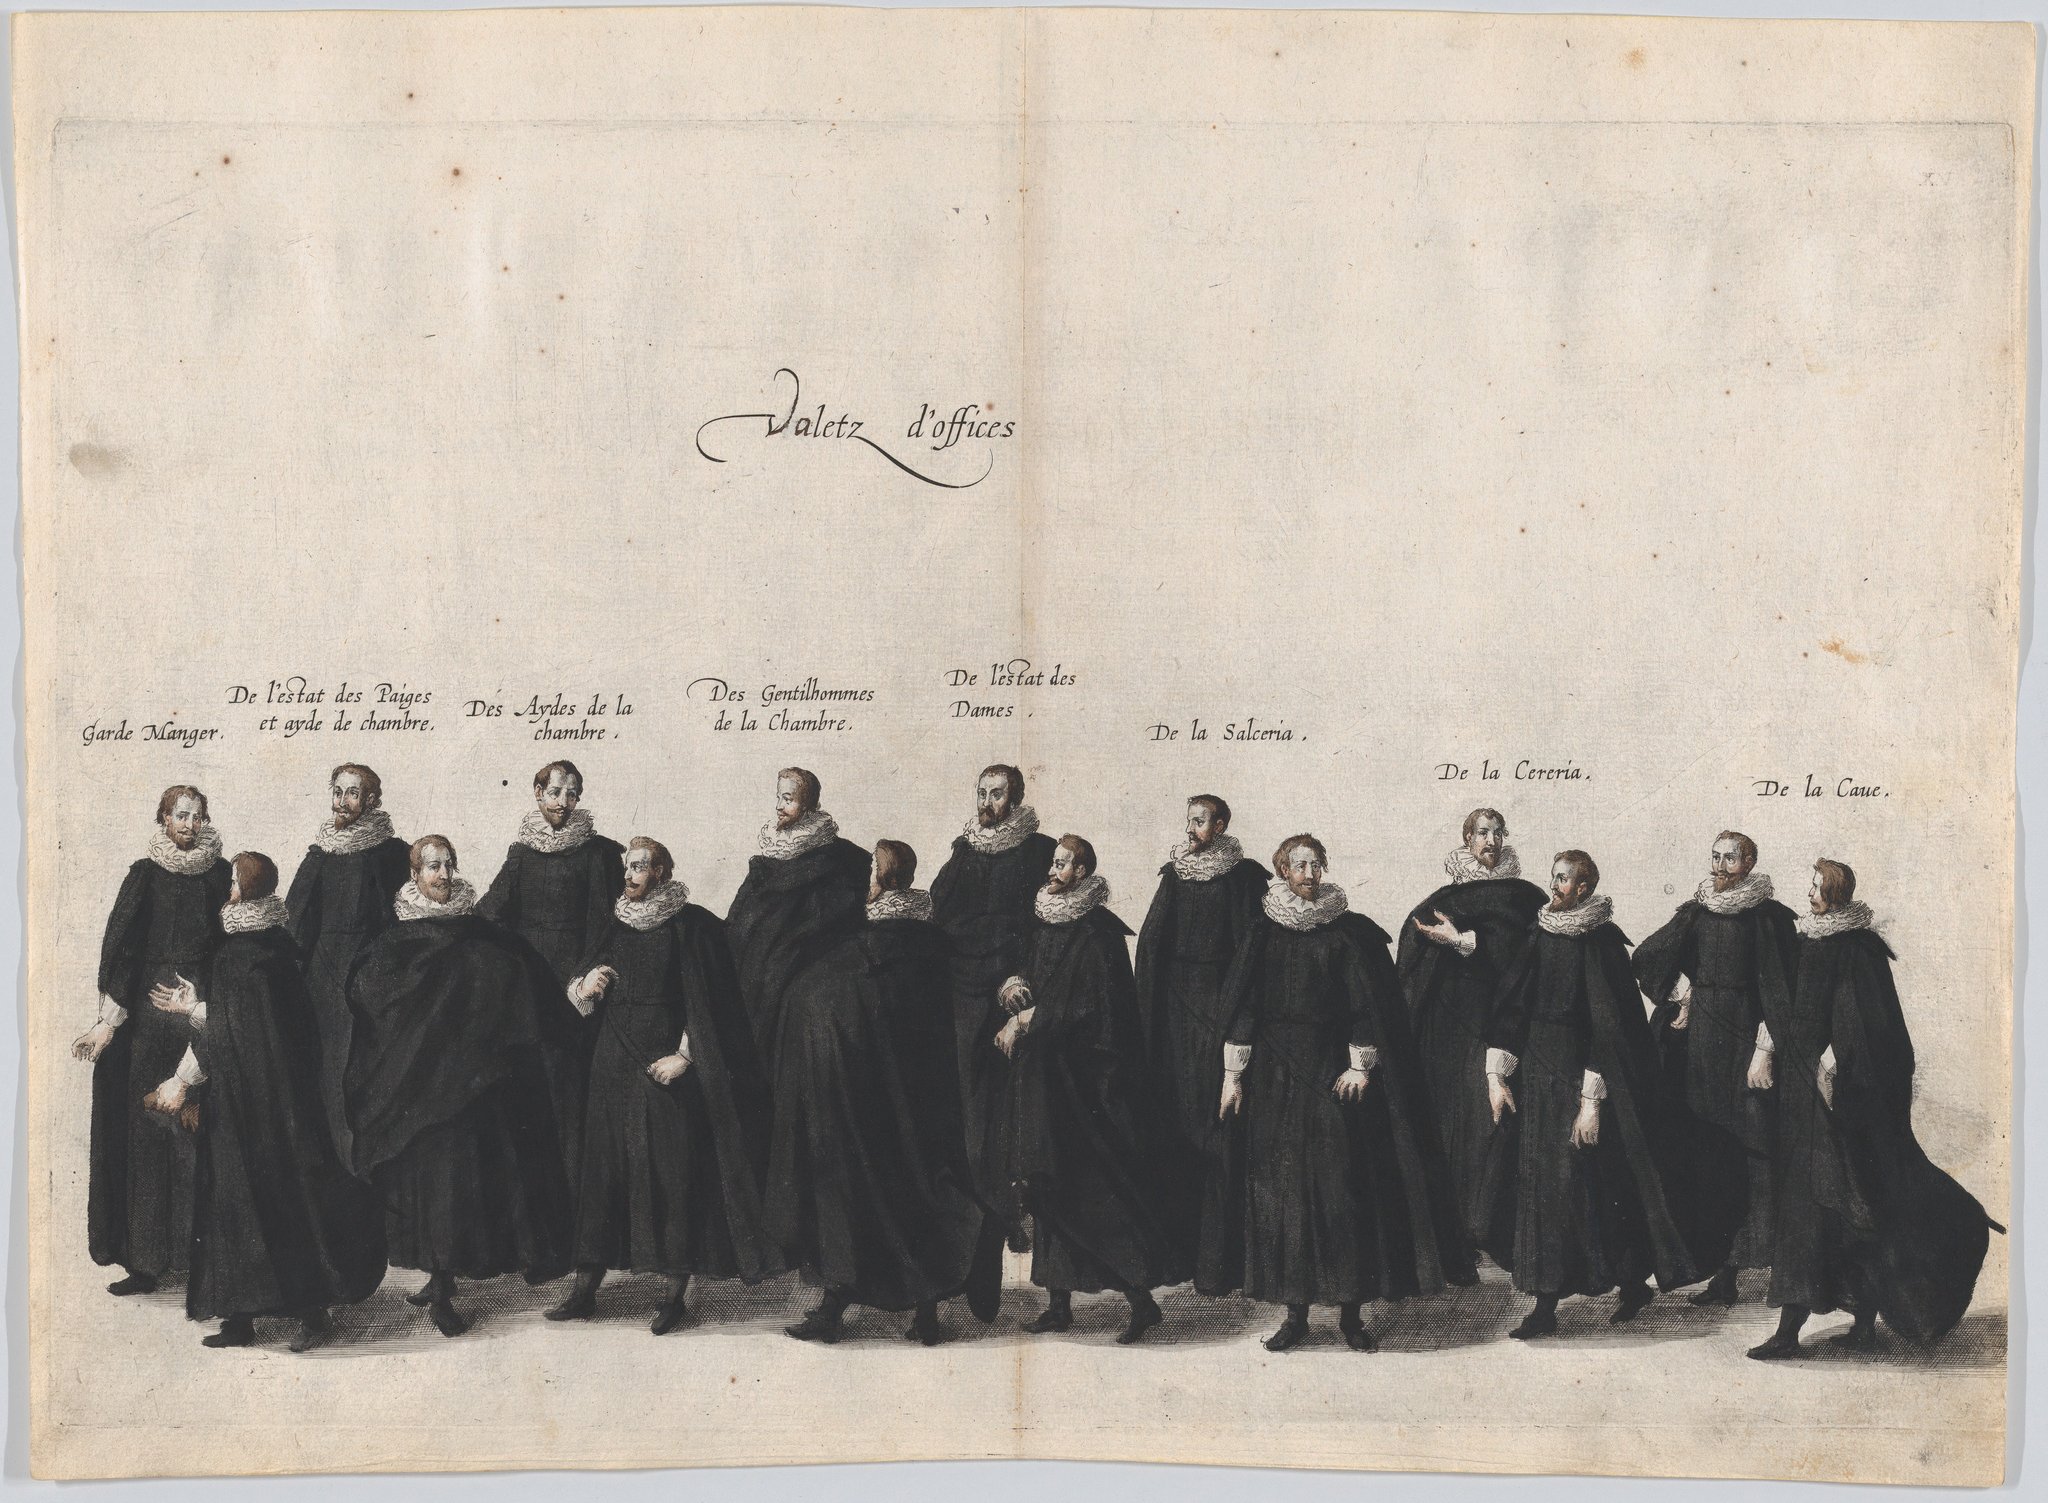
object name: print, fete, ornament architecture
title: Plate 15: Valets marching in the funeral procession of Archduke Albert of Austria; from 'Pompa Funebris ... Alberti Pii'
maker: cornelis galle (i)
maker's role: artist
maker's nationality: netherlandish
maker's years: 1576-1650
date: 1623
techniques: etching, hand coloring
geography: brussels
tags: men